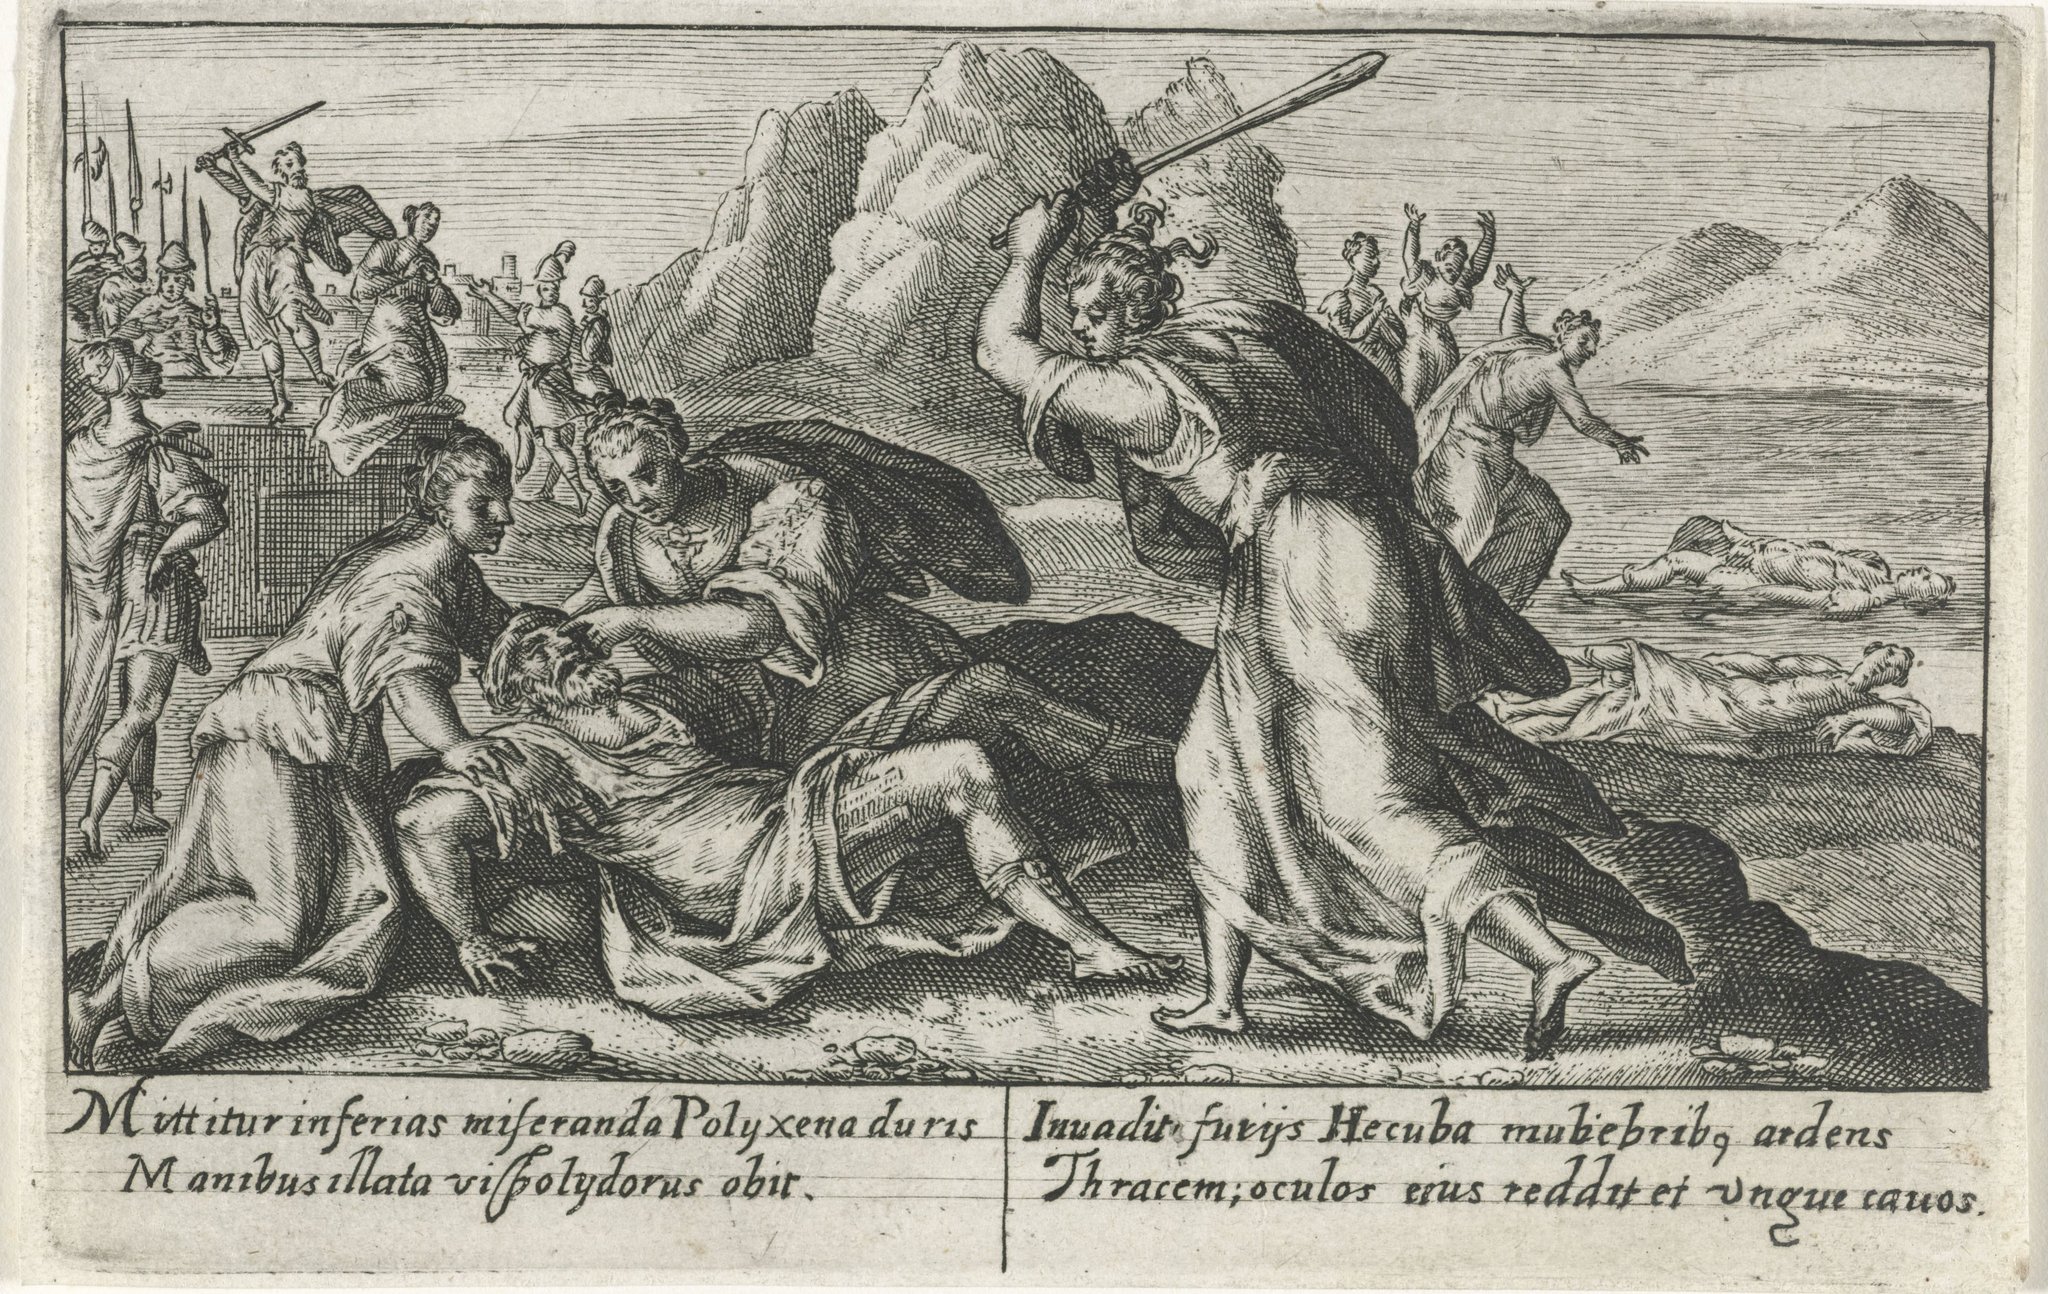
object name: print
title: Hekuba krabt de ogen van Polymestor uit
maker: crispijn van de passe (i)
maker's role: draughtsman, print maker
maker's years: 1564-1637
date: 1602-1607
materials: paper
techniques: engraving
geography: cologne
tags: hecuba finds her dead son polydorus on the sea-shore, hecuba tears out polymnestor's eyes and kills his two sons, polyxena is sacrificed by neoptolemus on achilles' tomb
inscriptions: collector's mark: Lugt 2228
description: Om de moord op haar zoon te wreken krabt Hekuba de ogen van de Thrakiër Polymestor uit. Links op de achtergrond wordt Polyxena, de dochter van Hekuba, door Neoptolemus geofferd. Rechts op de achtergrond Hekuba die het lijk van haar zoon Polydorus vindt, dat is aangespoeld op het strand. In de marge een vierregelig onderschrift, in twee kolommen, in het Latijn.